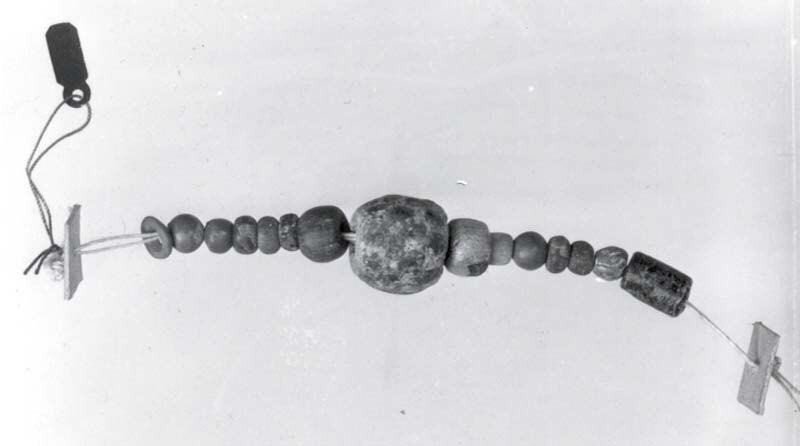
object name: bead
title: Beads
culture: sasanian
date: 201-700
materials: glass, stone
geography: iran